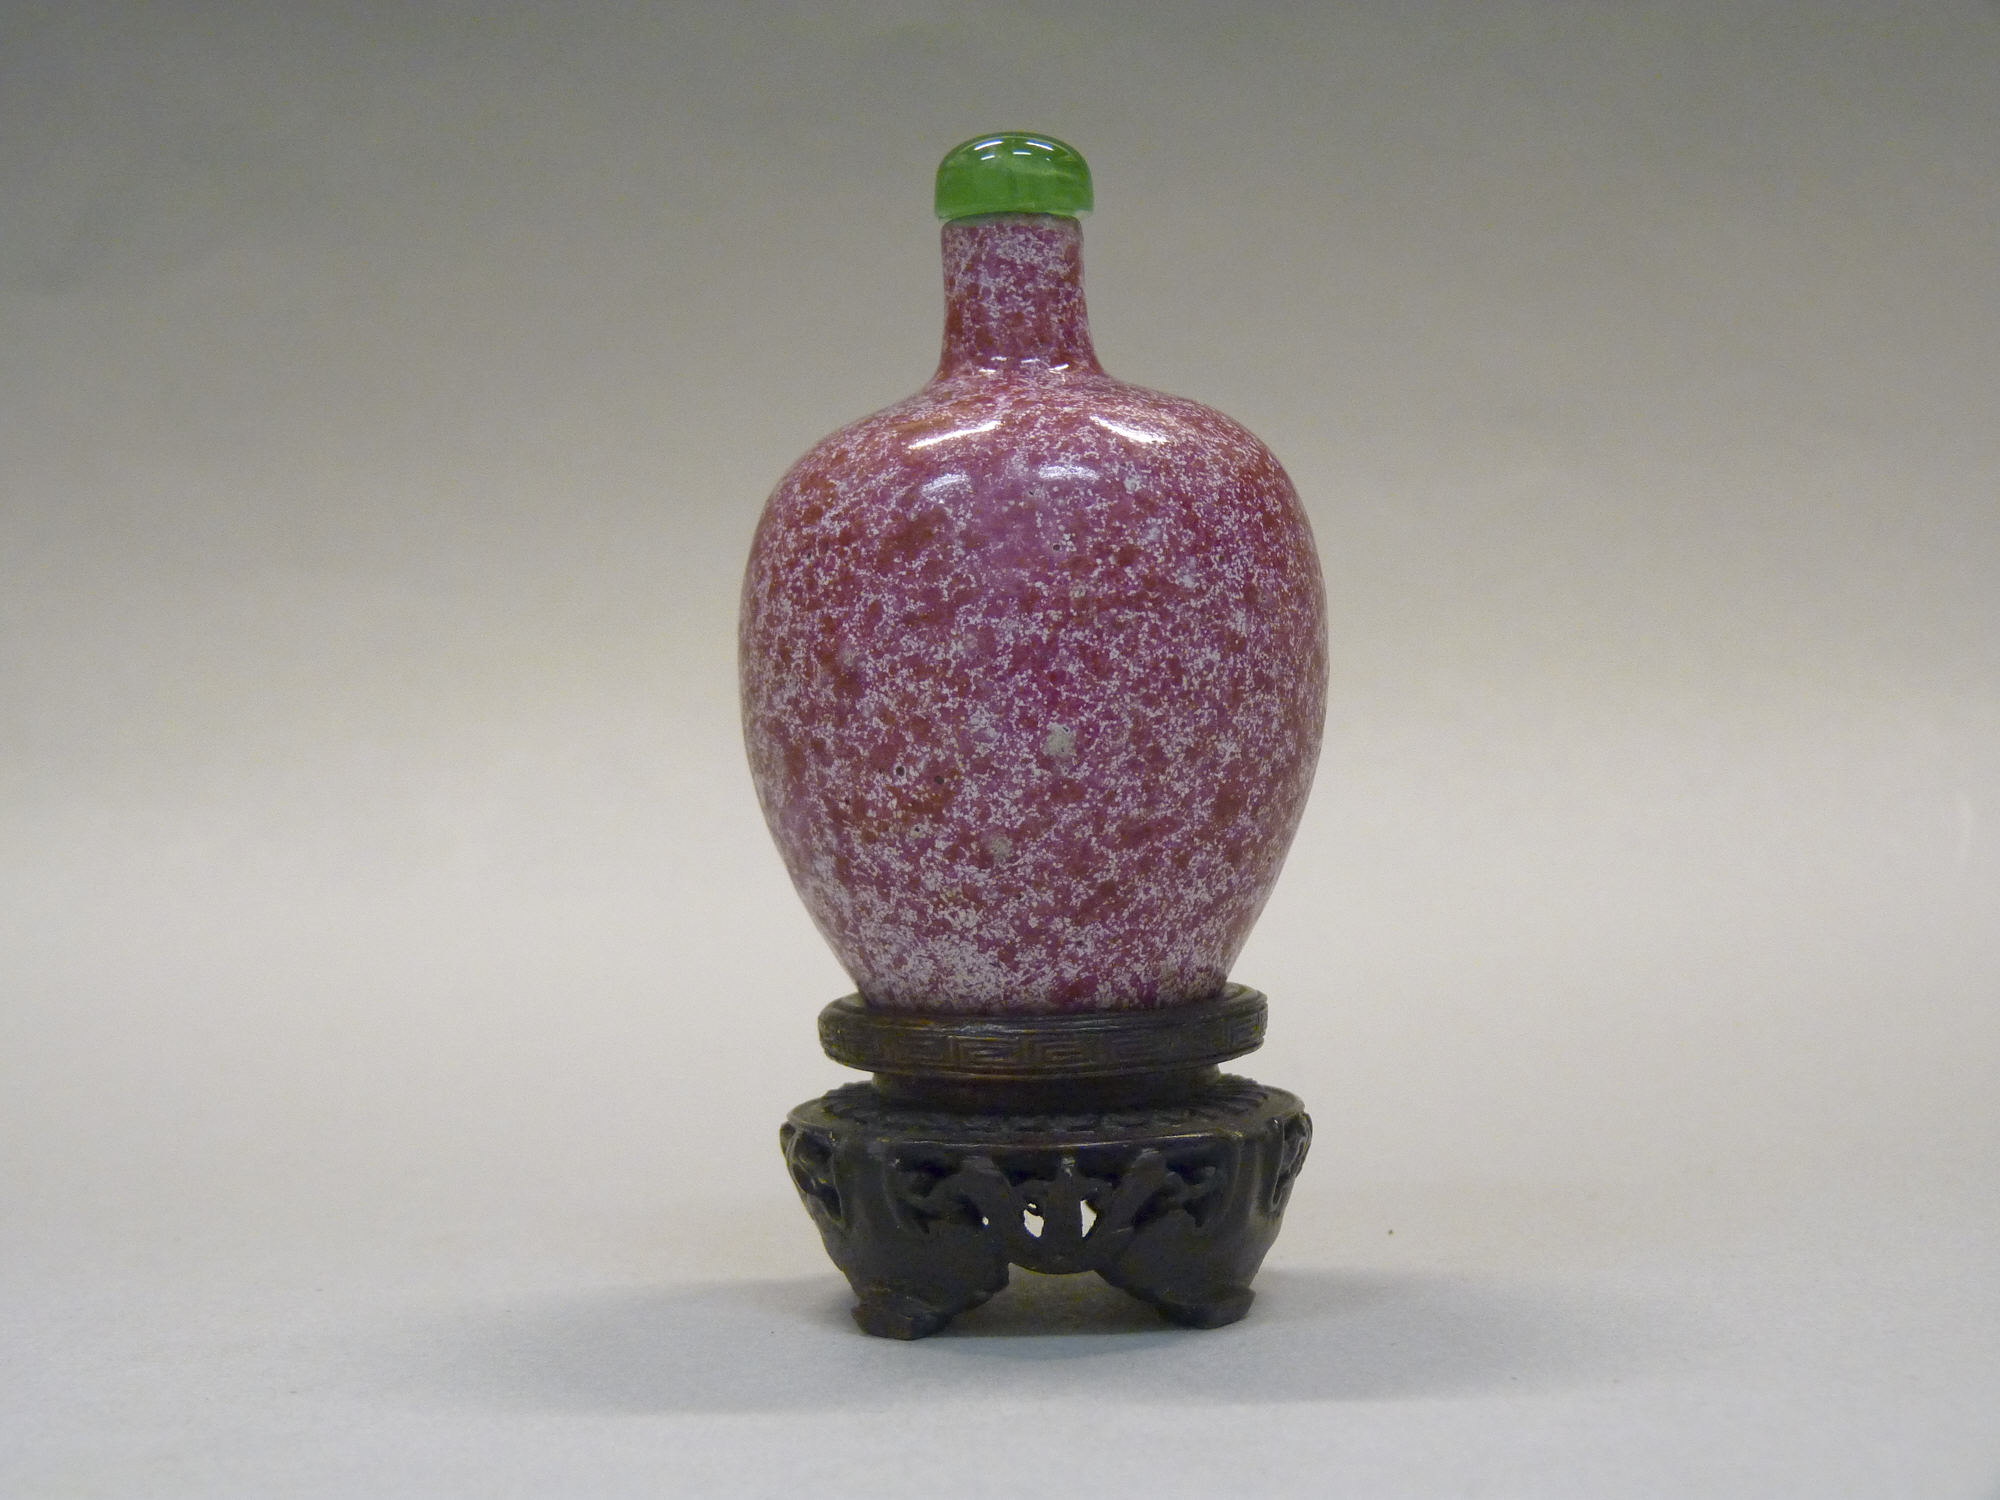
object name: snuff bottle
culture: chinese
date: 1736-1795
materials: glass, porcelain